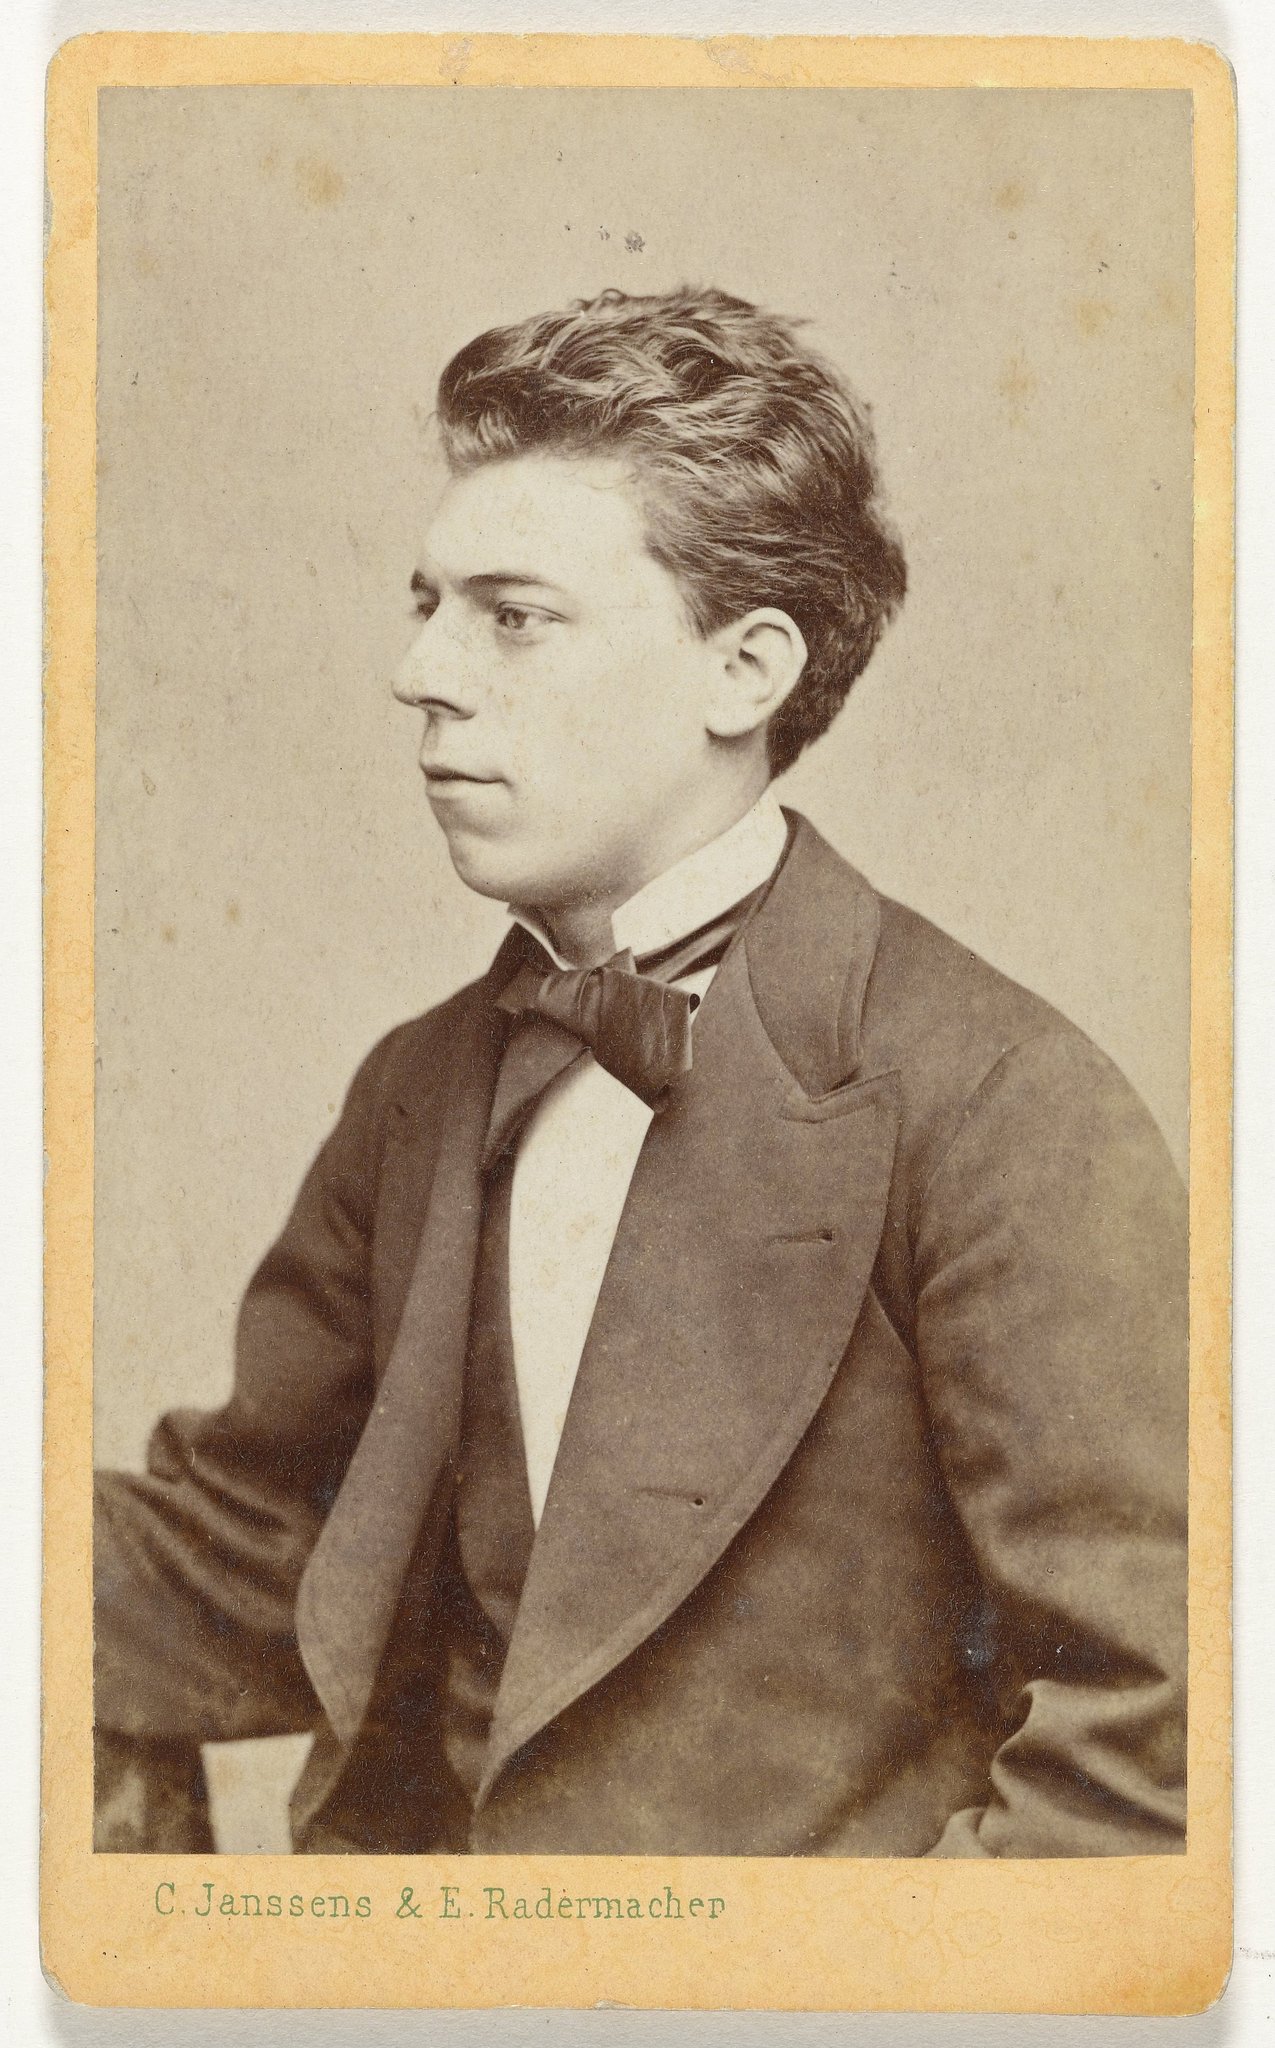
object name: carte de visite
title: Portret van een jongeman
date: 1871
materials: cardboard, paper, photographic support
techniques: albumen print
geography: rotterdam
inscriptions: address: ‘C. Janssens/&/E. Radermacher/Photohgraphes/Hofplein 14.341/Rotterdam’, annotation: ‘Aan mijn vriend Johan/Dachlig, ter herinnering aan/Chr. Mac.../17 Mei 1871’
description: Zittende jongeman met dik, achterovergekamd haar, ten halven lijve naar links.